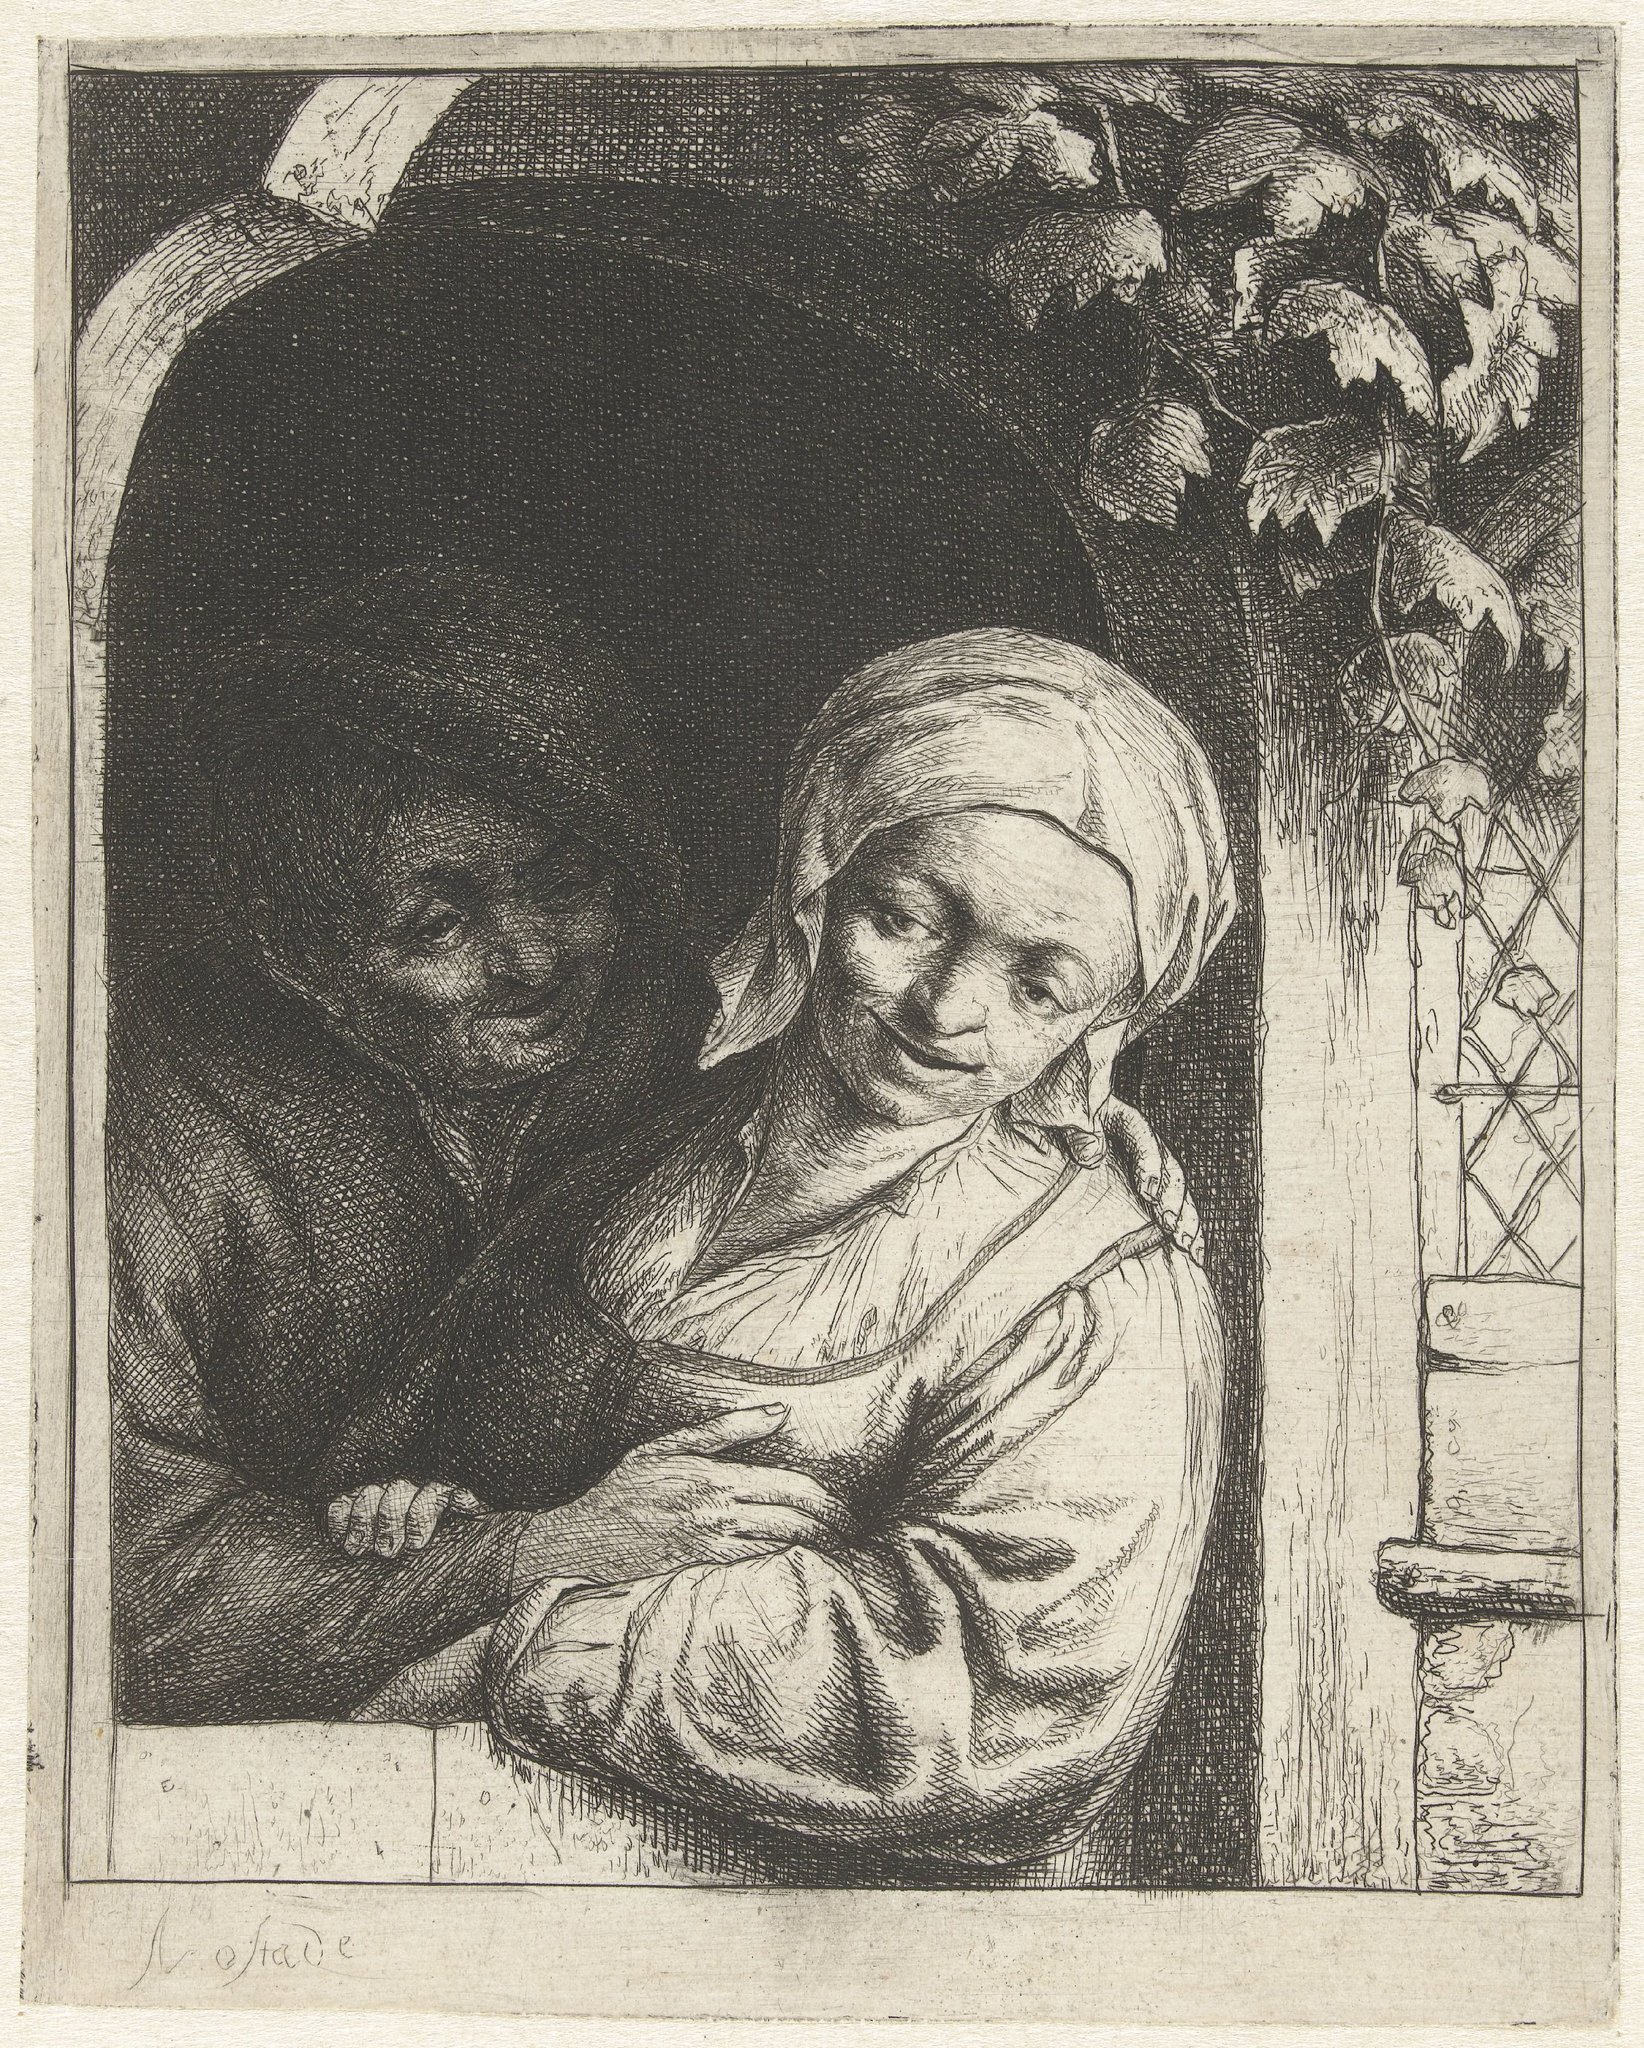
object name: print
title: Het boerenliefdespaar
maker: adriaen van ostade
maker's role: draughtsman, painter, print maker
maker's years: 1610-1685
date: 1650-1654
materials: paper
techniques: etching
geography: haarlem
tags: couple of lovers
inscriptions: collector's mark: Lugt 2233, collector's mark: ‘moeilijk leesbaar’